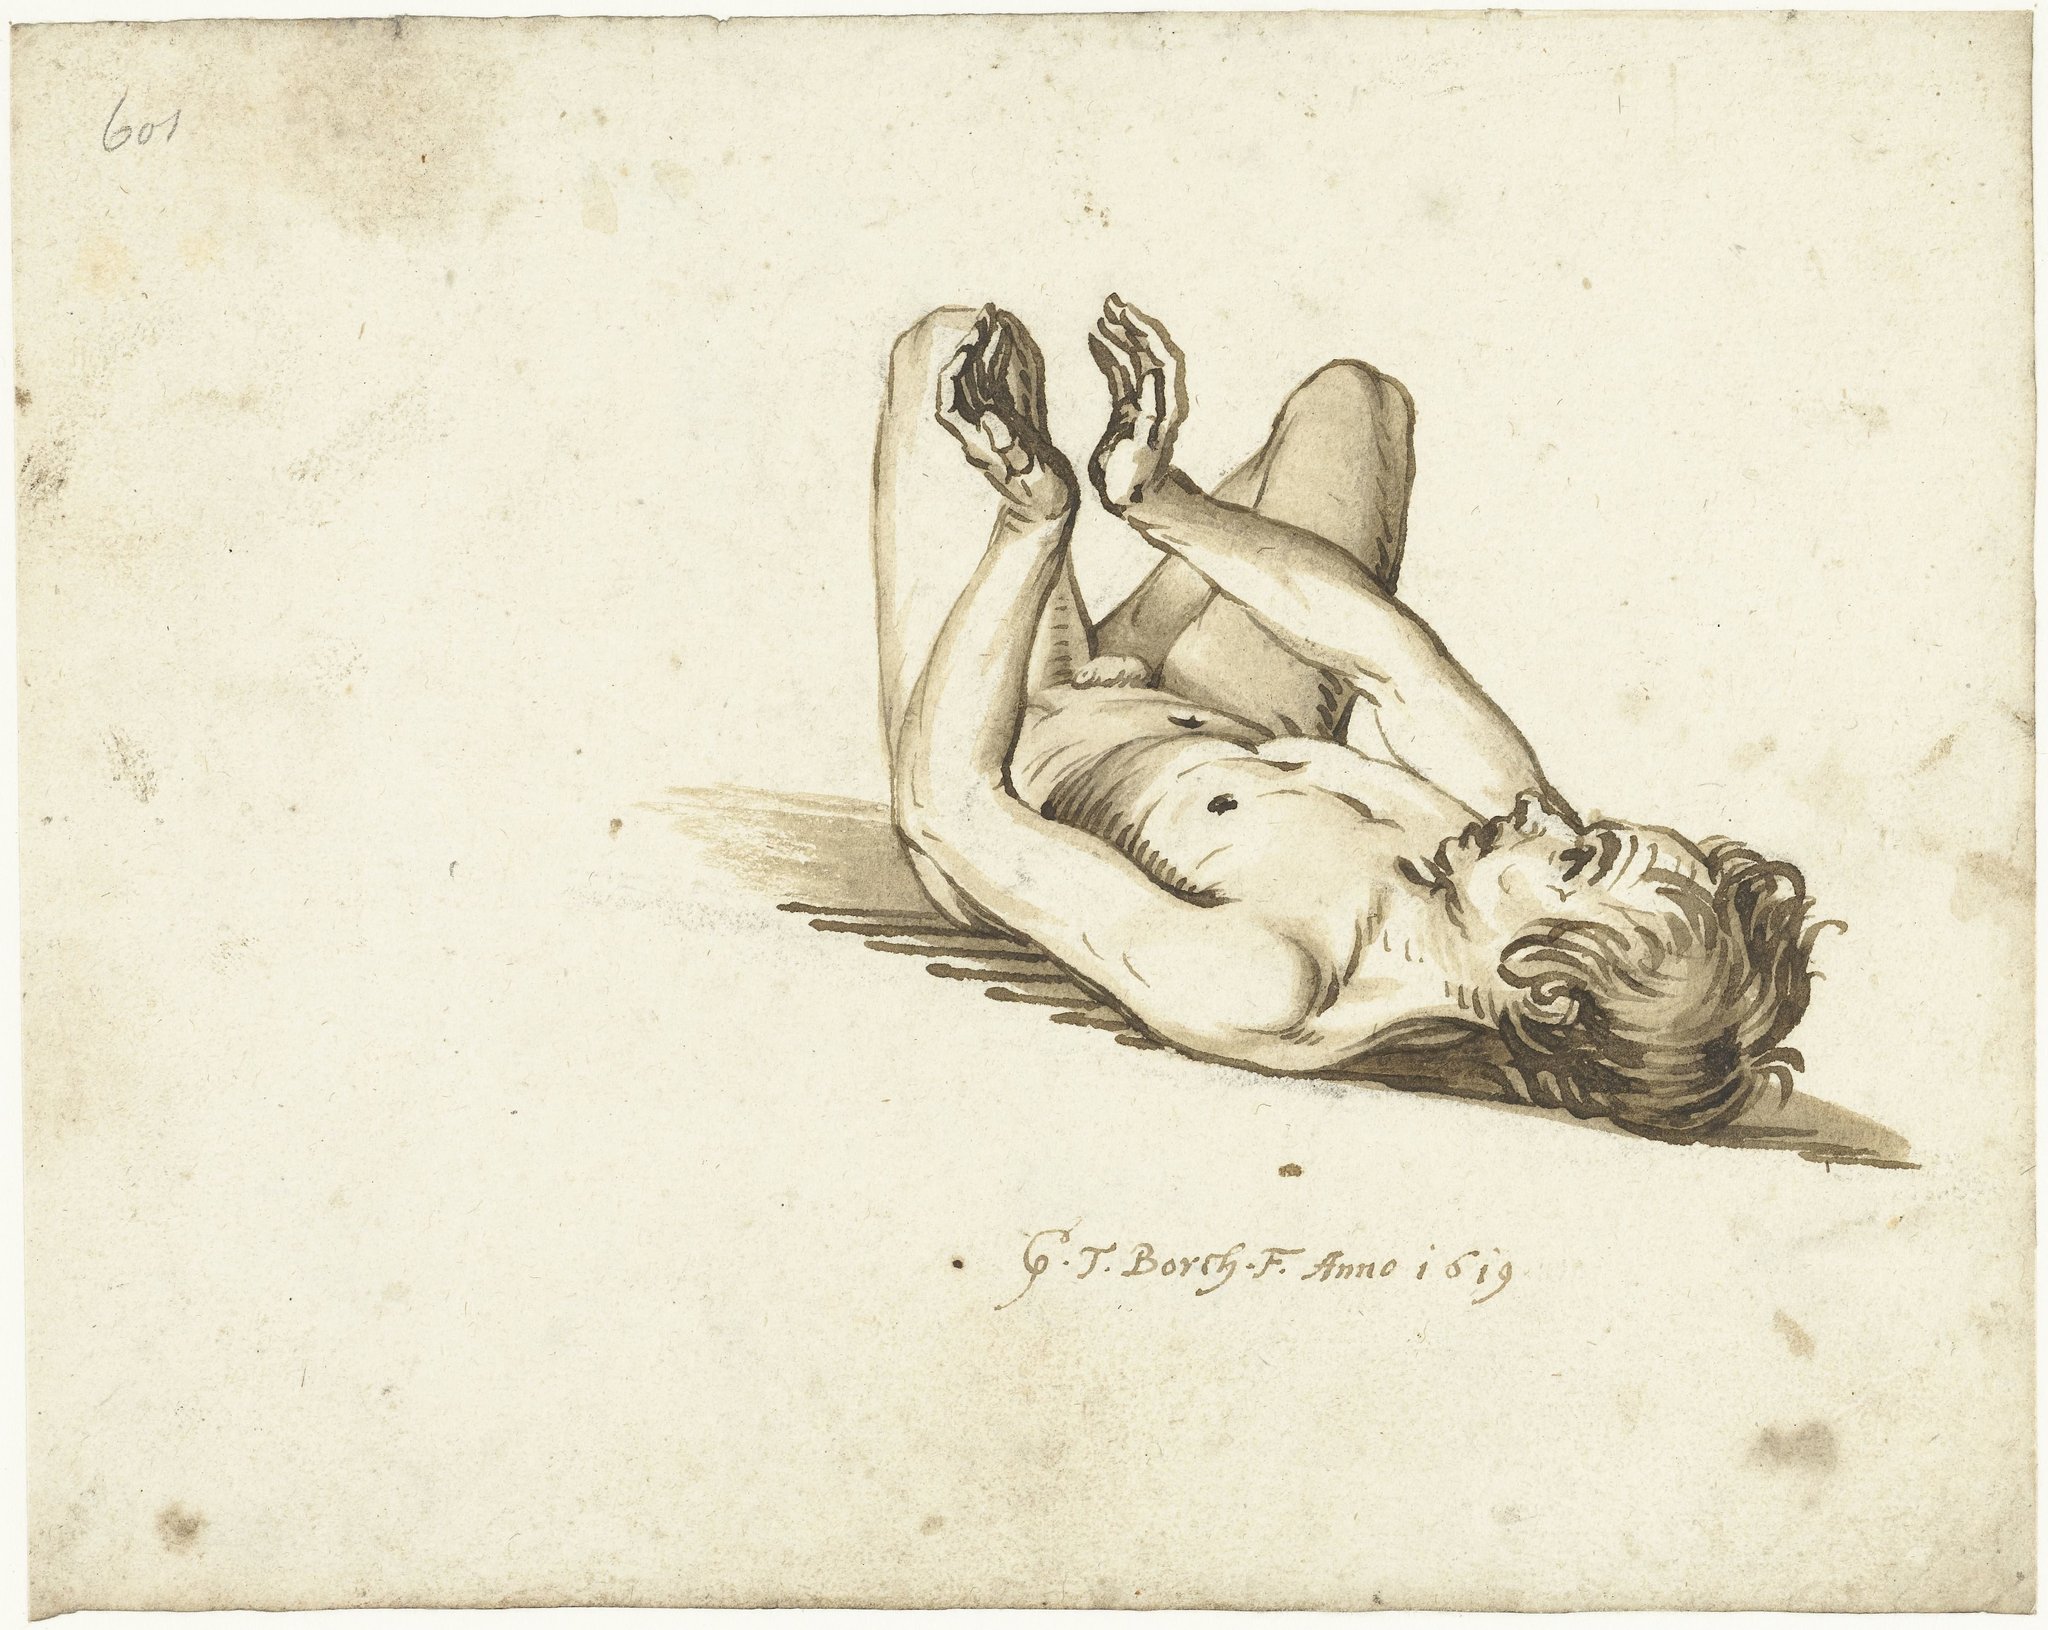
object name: drawing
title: Studie van de figuur van Isaac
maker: gerard ter borch (i)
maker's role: draughtsman, print maker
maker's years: 1584-1662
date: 1619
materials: chalk, ink, paper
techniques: brush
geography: zwolle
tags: the sacrifice of isaac (genesis 22)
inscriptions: signature and date: ‘G.T.Borch.F.Anno 1619.’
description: Studie van de figuur van Isaac voor de uitgewerkte tekening 'Abraham's offer van Isaac' (GSr 72).